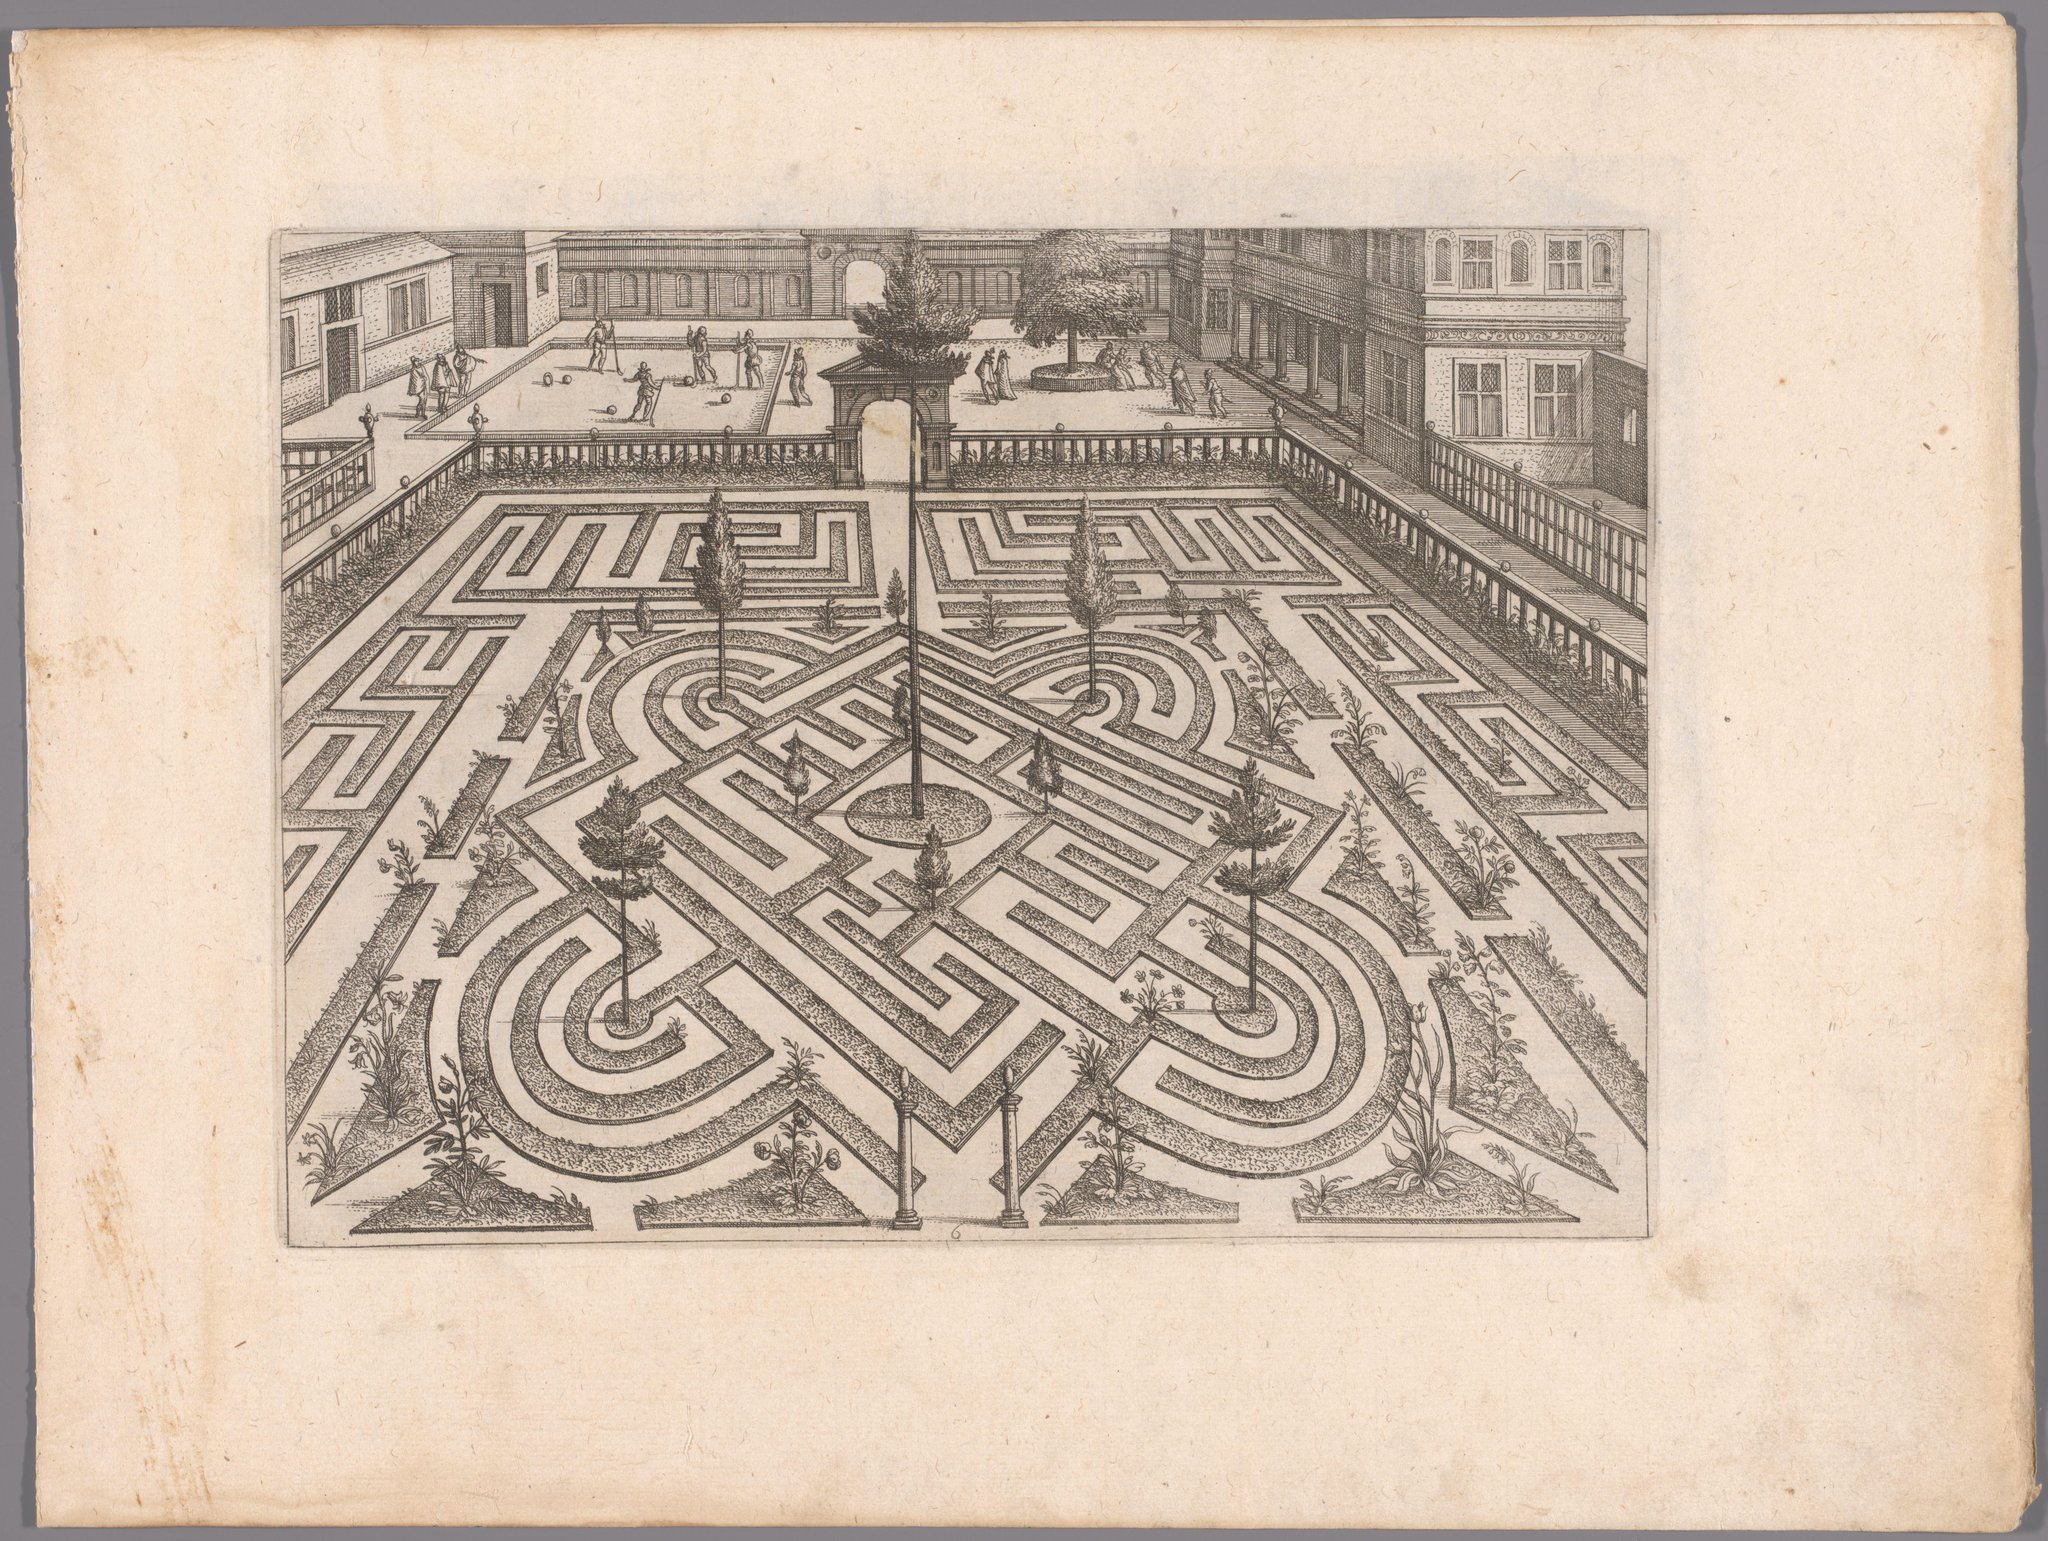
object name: ornament print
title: Tuinen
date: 1587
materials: paper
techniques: etching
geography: antwerp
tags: garden, labyrinth, maze ~ garden, 'kolf' (ball game)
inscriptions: collector's mark: Lugt 2228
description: Tuin met een parterre gevormd door lage perkjes in een geometrisch patroon, bestaande uit een ruit met halfronde uitstulpingen op de rechte zijden. Op de achtergrond ligt een plein waarop mensen kolf spelen.